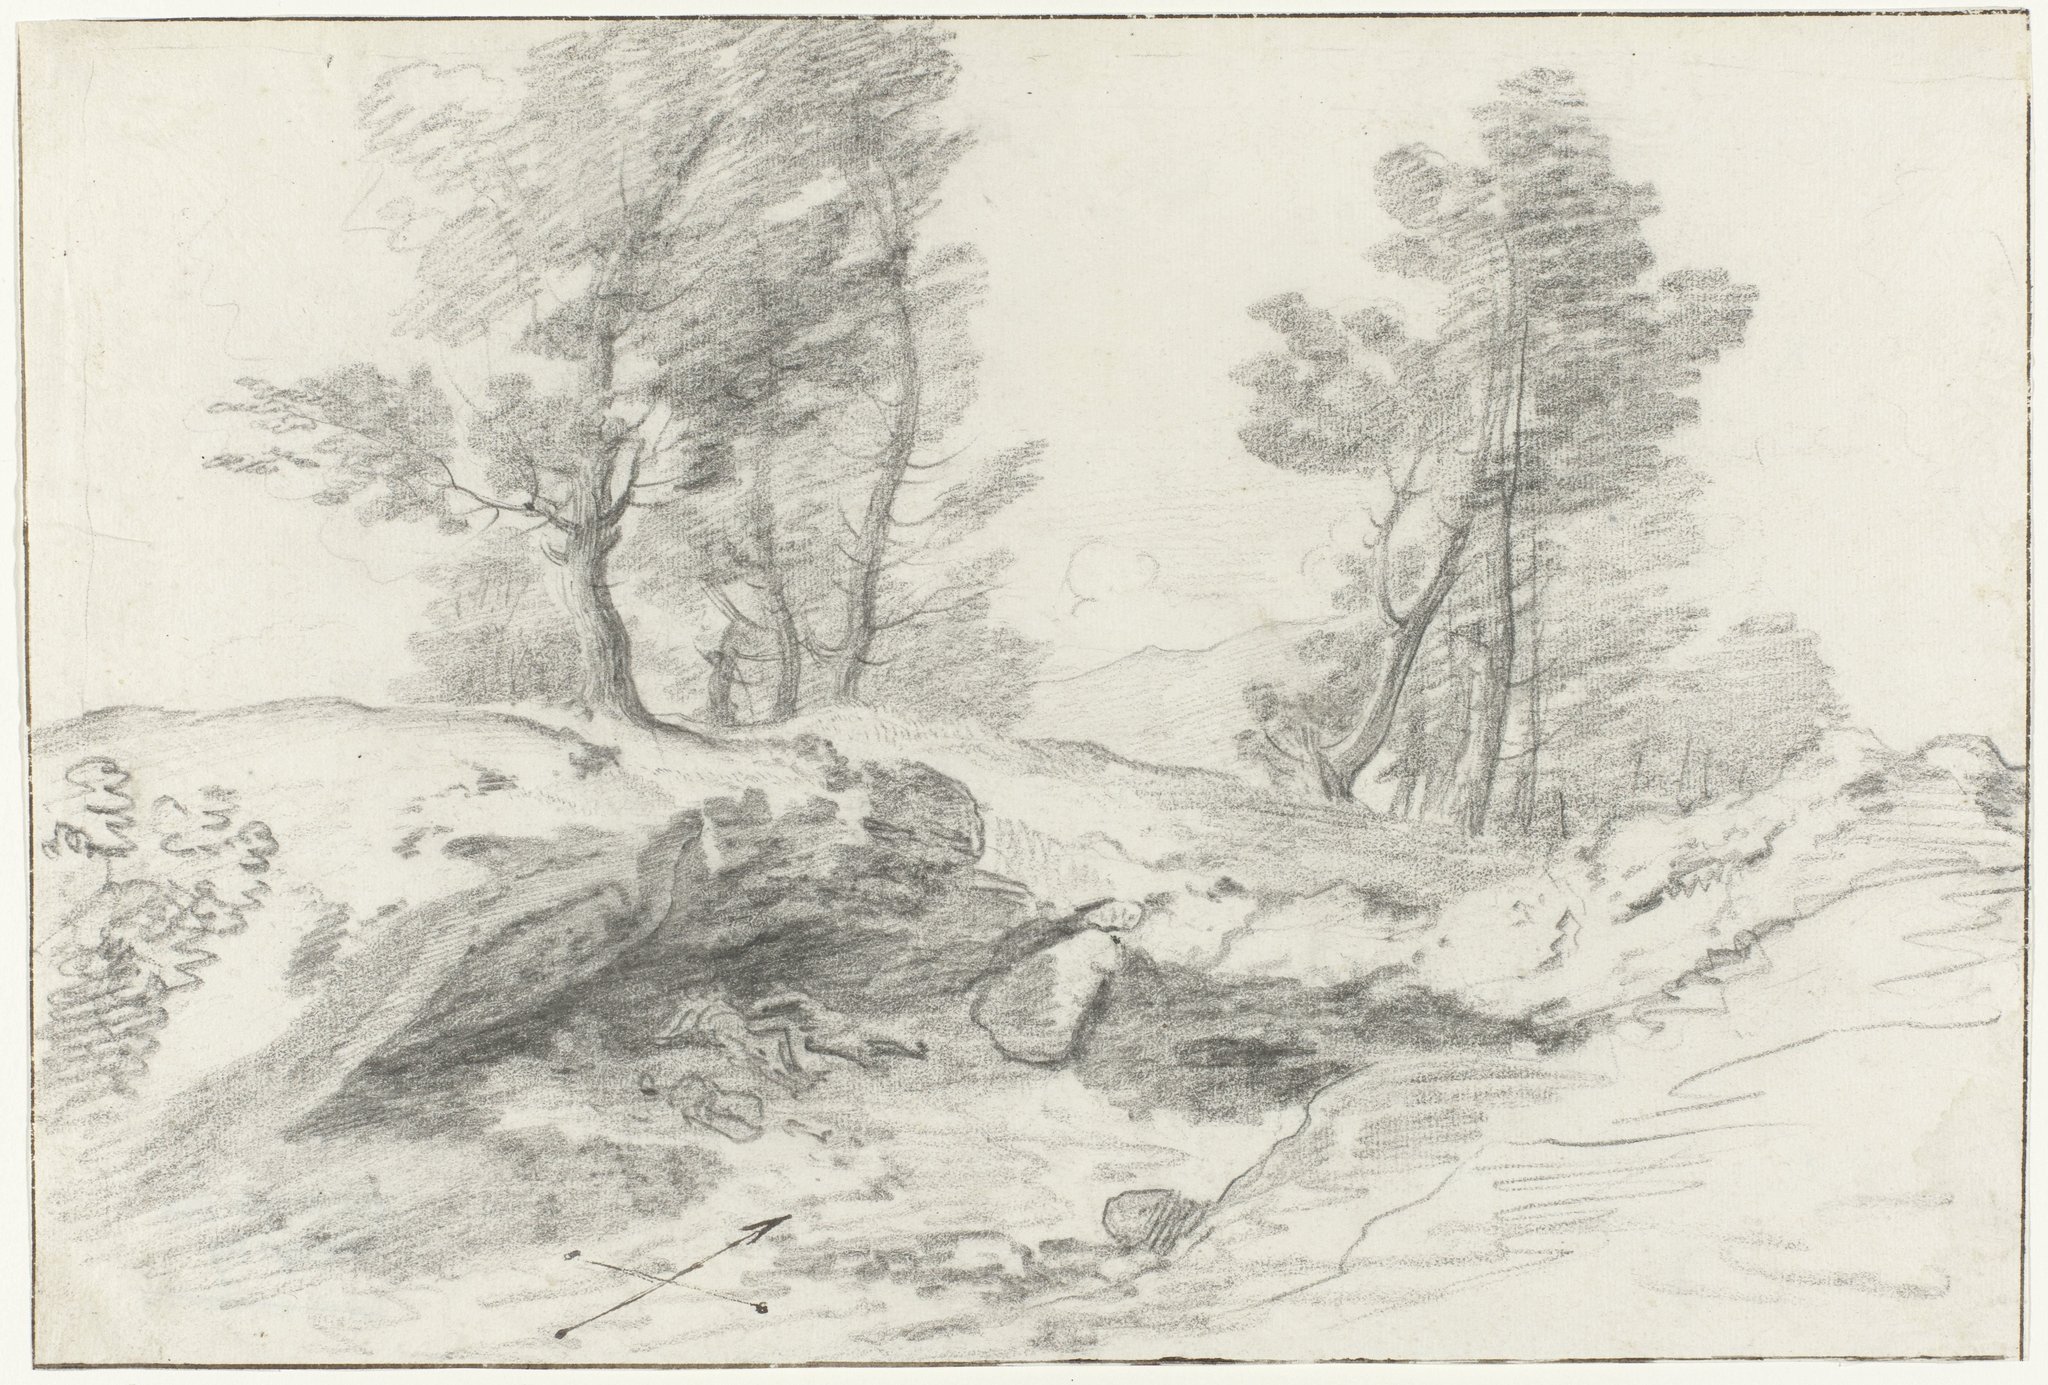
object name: drawing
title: Voyage en Italie, en Sicile et à Malte - 1778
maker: louis mayer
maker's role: draughtsman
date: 1778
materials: chalk, paper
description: Tekening uit het album 'Voyage en Italie, en Sicile et à Malte', 1778.